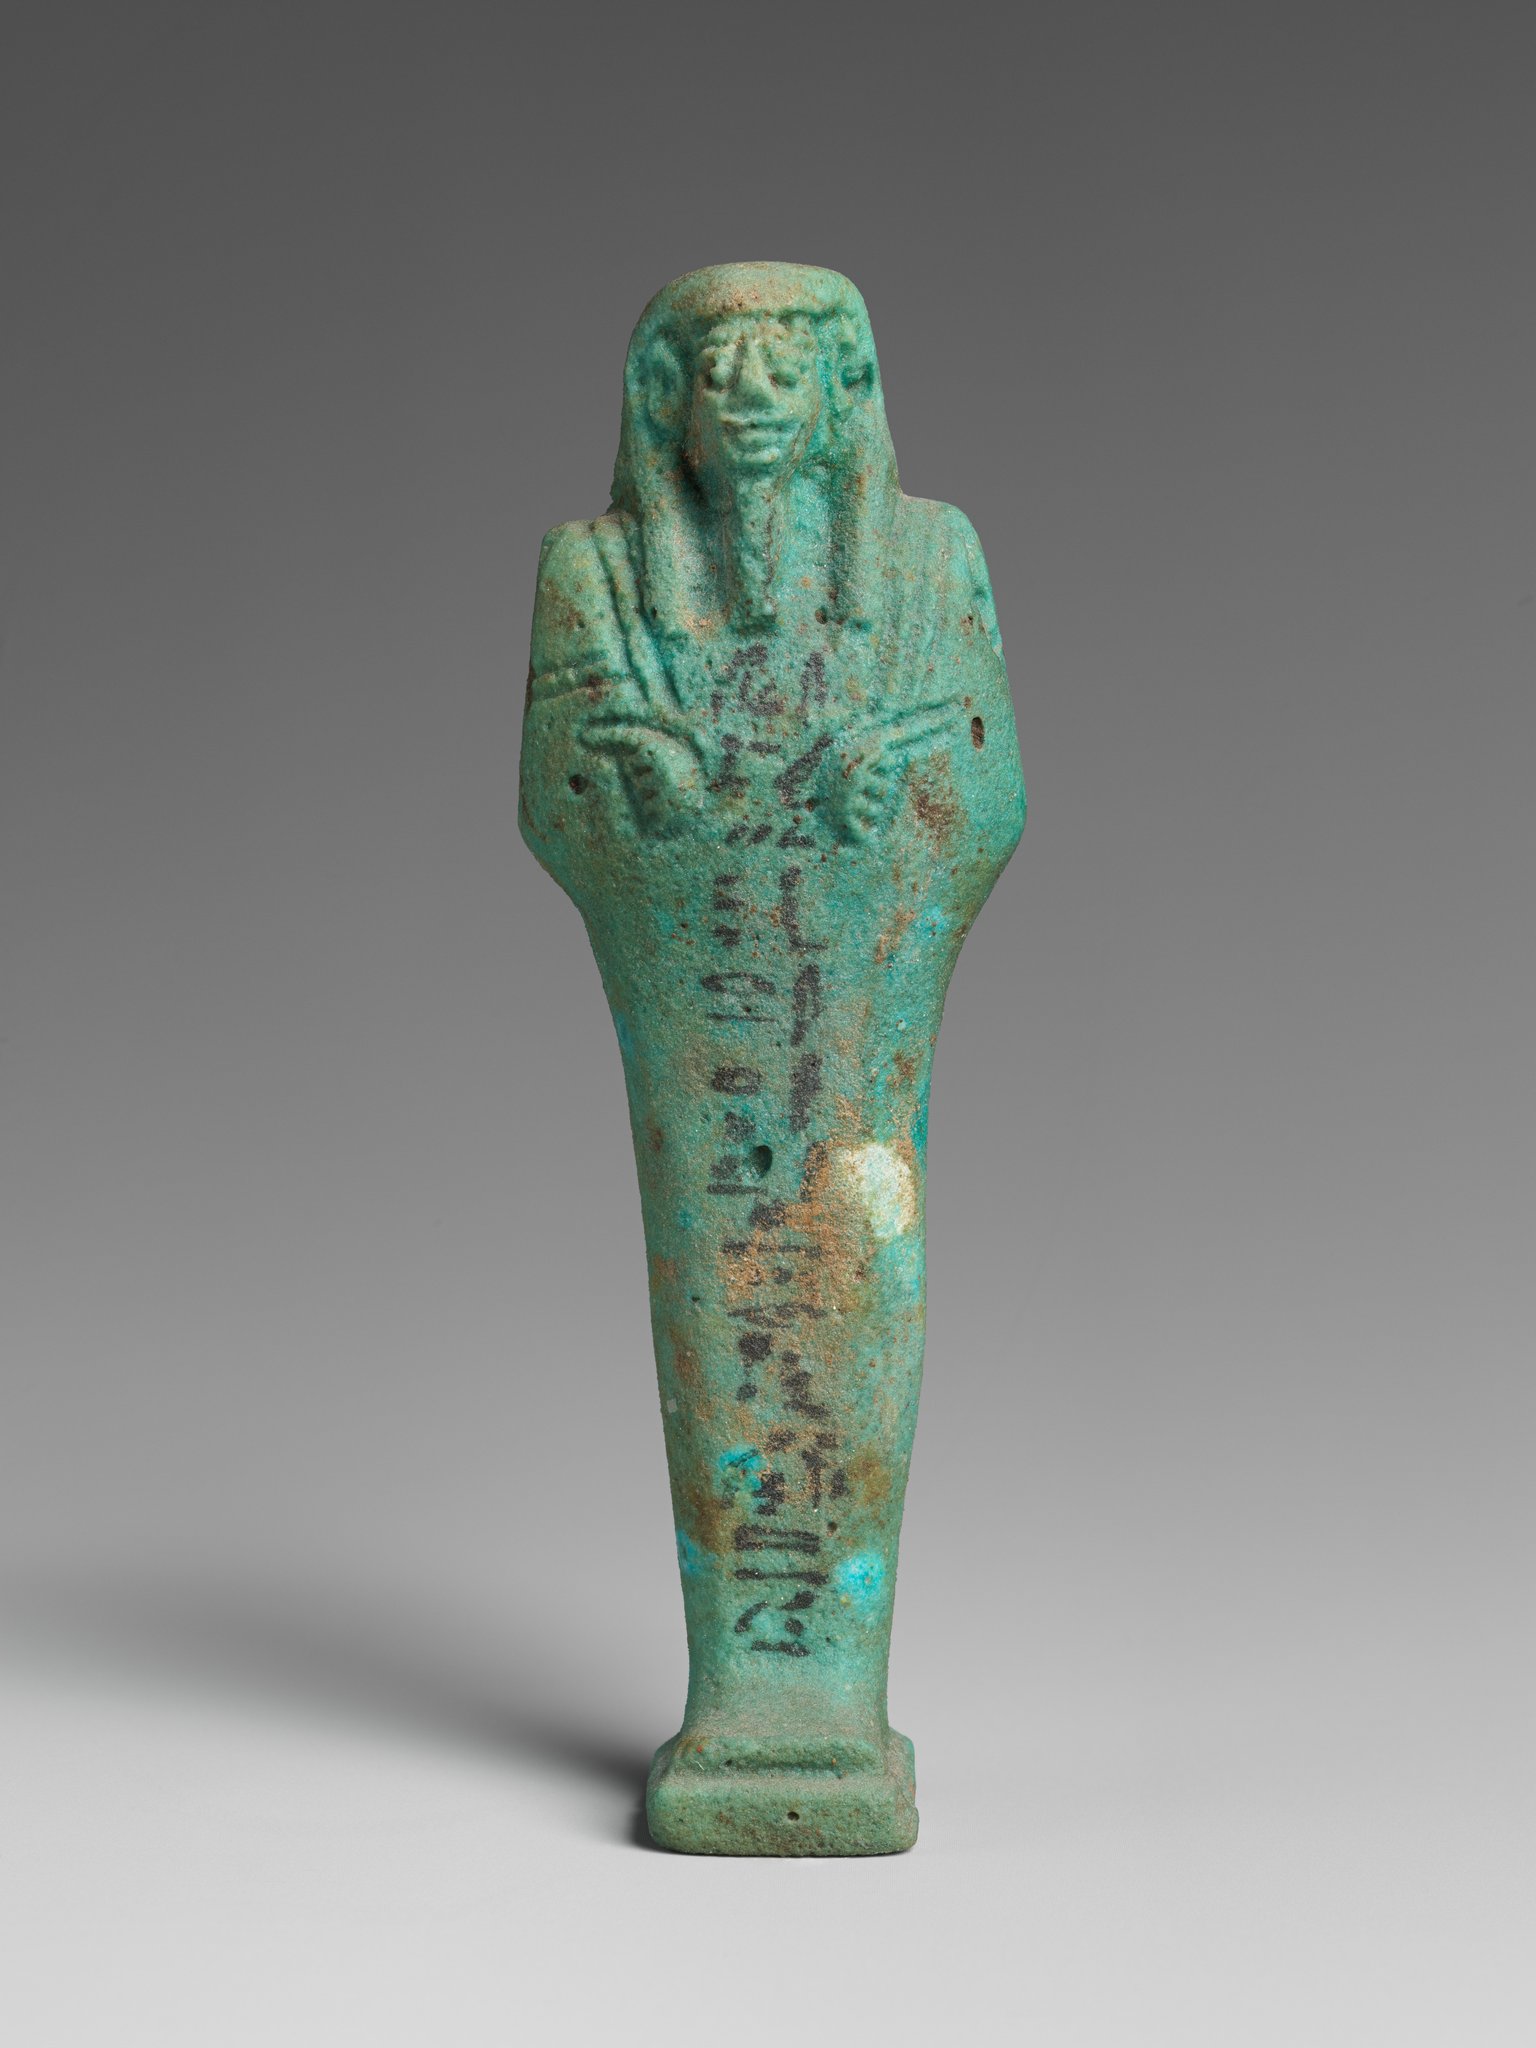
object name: shabti, djedhor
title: Shabti of Djedhor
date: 360-300 BCE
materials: faience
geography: egypt